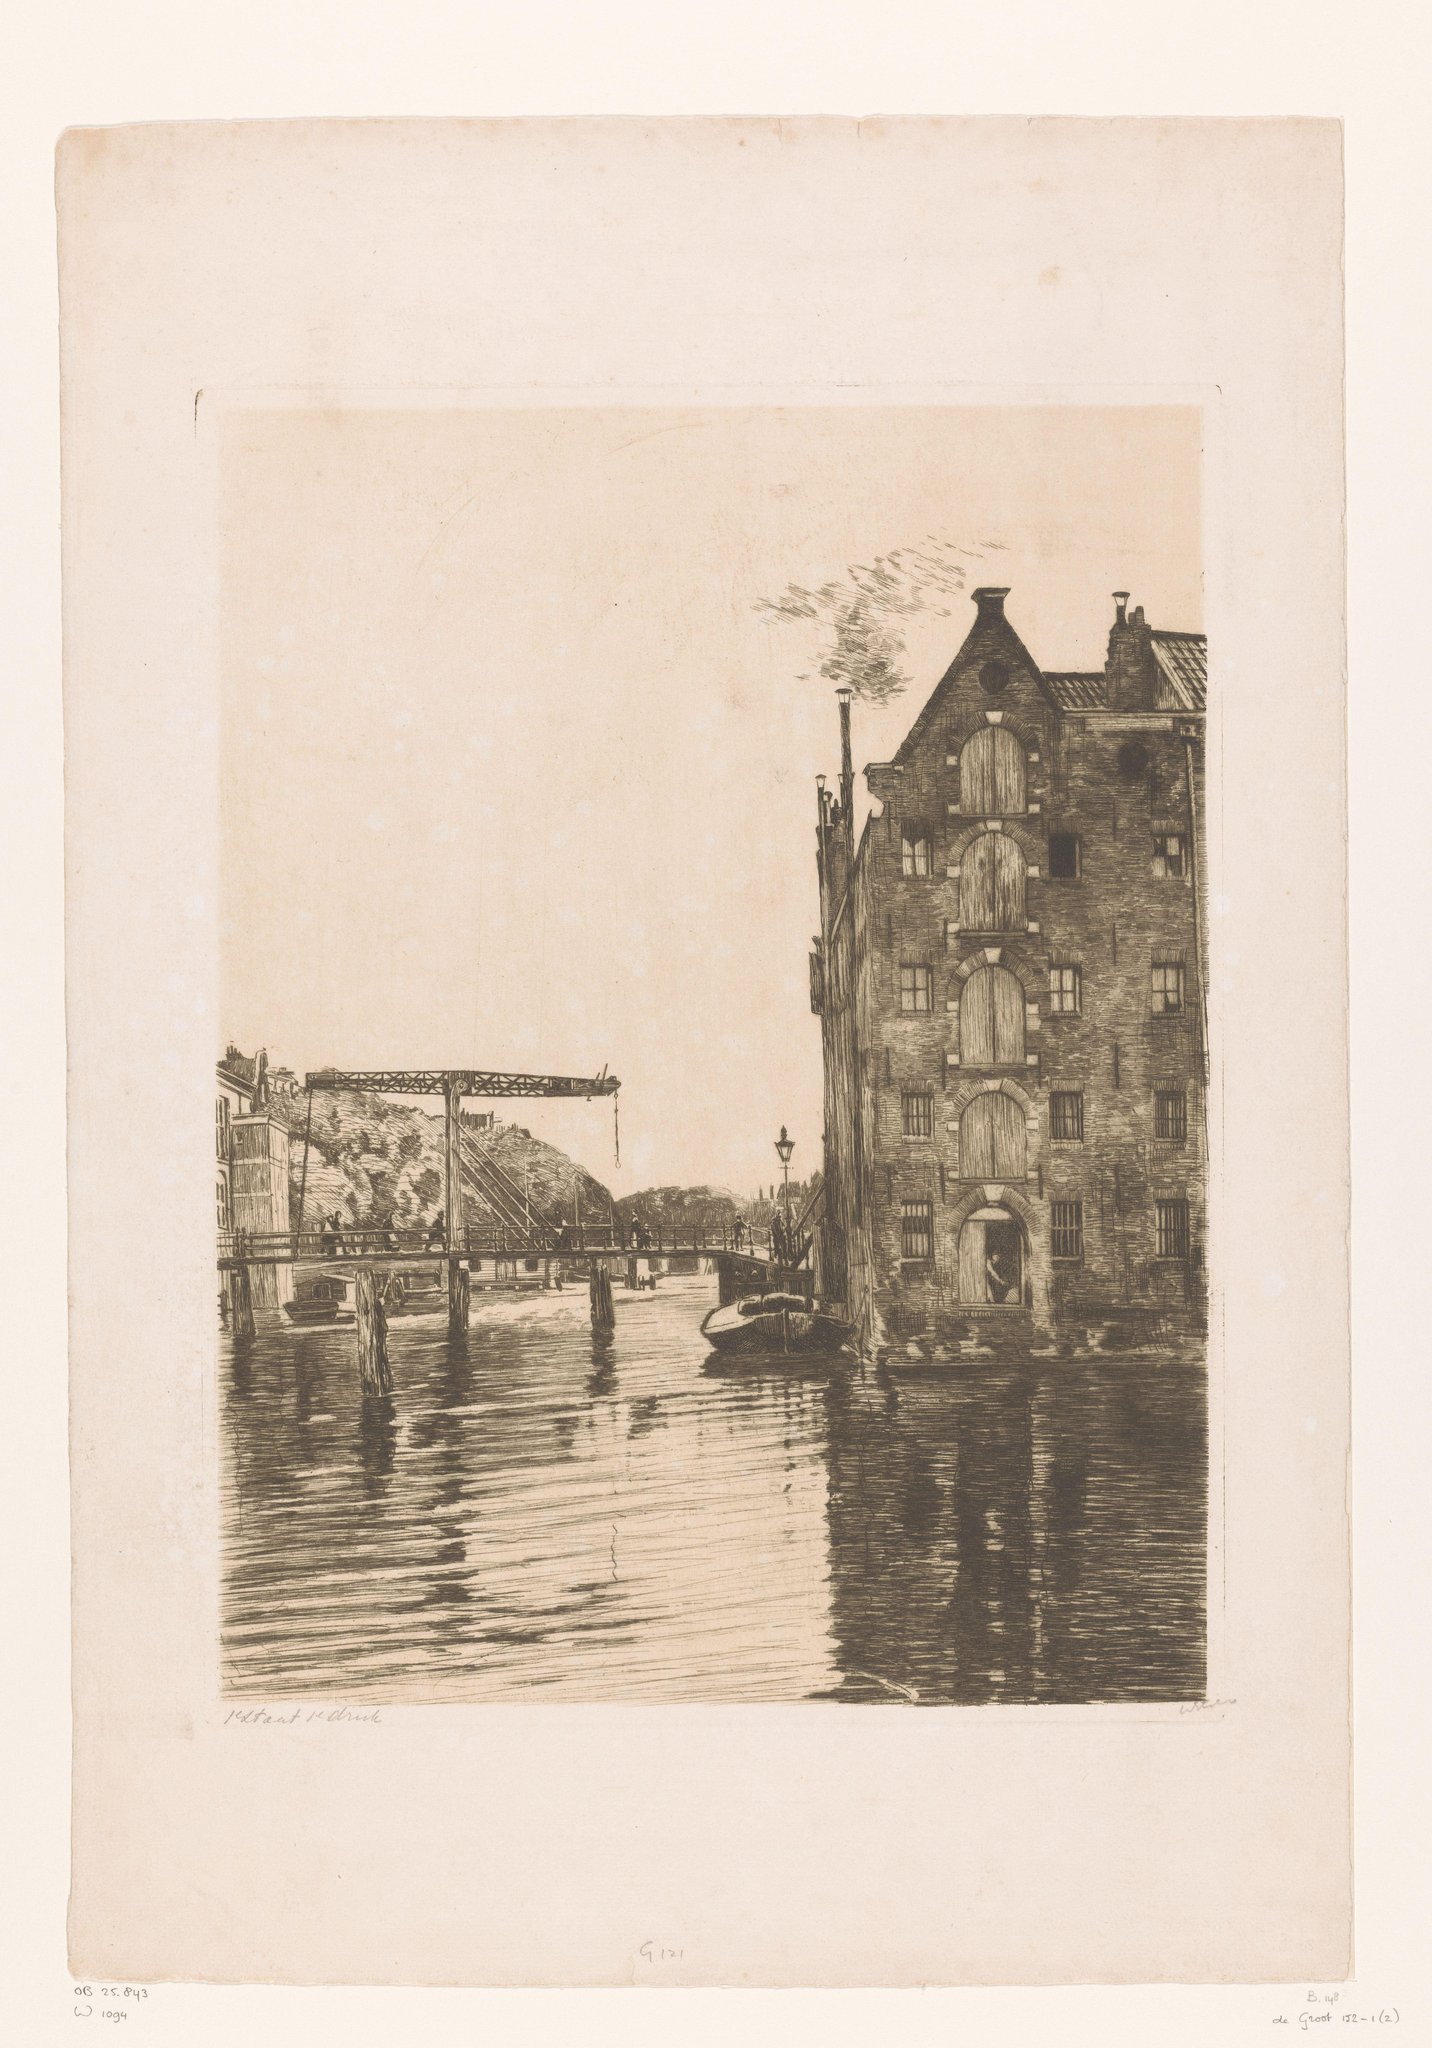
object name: print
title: Pakhuizen op Uilenburg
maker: willem witsen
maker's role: draughtsman, painter, print maker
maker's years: 1860-1923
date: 1911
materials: paper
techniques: etching, intaglio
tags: warehouse (~ harbour), bridges by construction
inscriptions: annotation: ‘2a/ 4/77 [in getekende driehoek]’, annotation: ‘1e staat 1e druk’